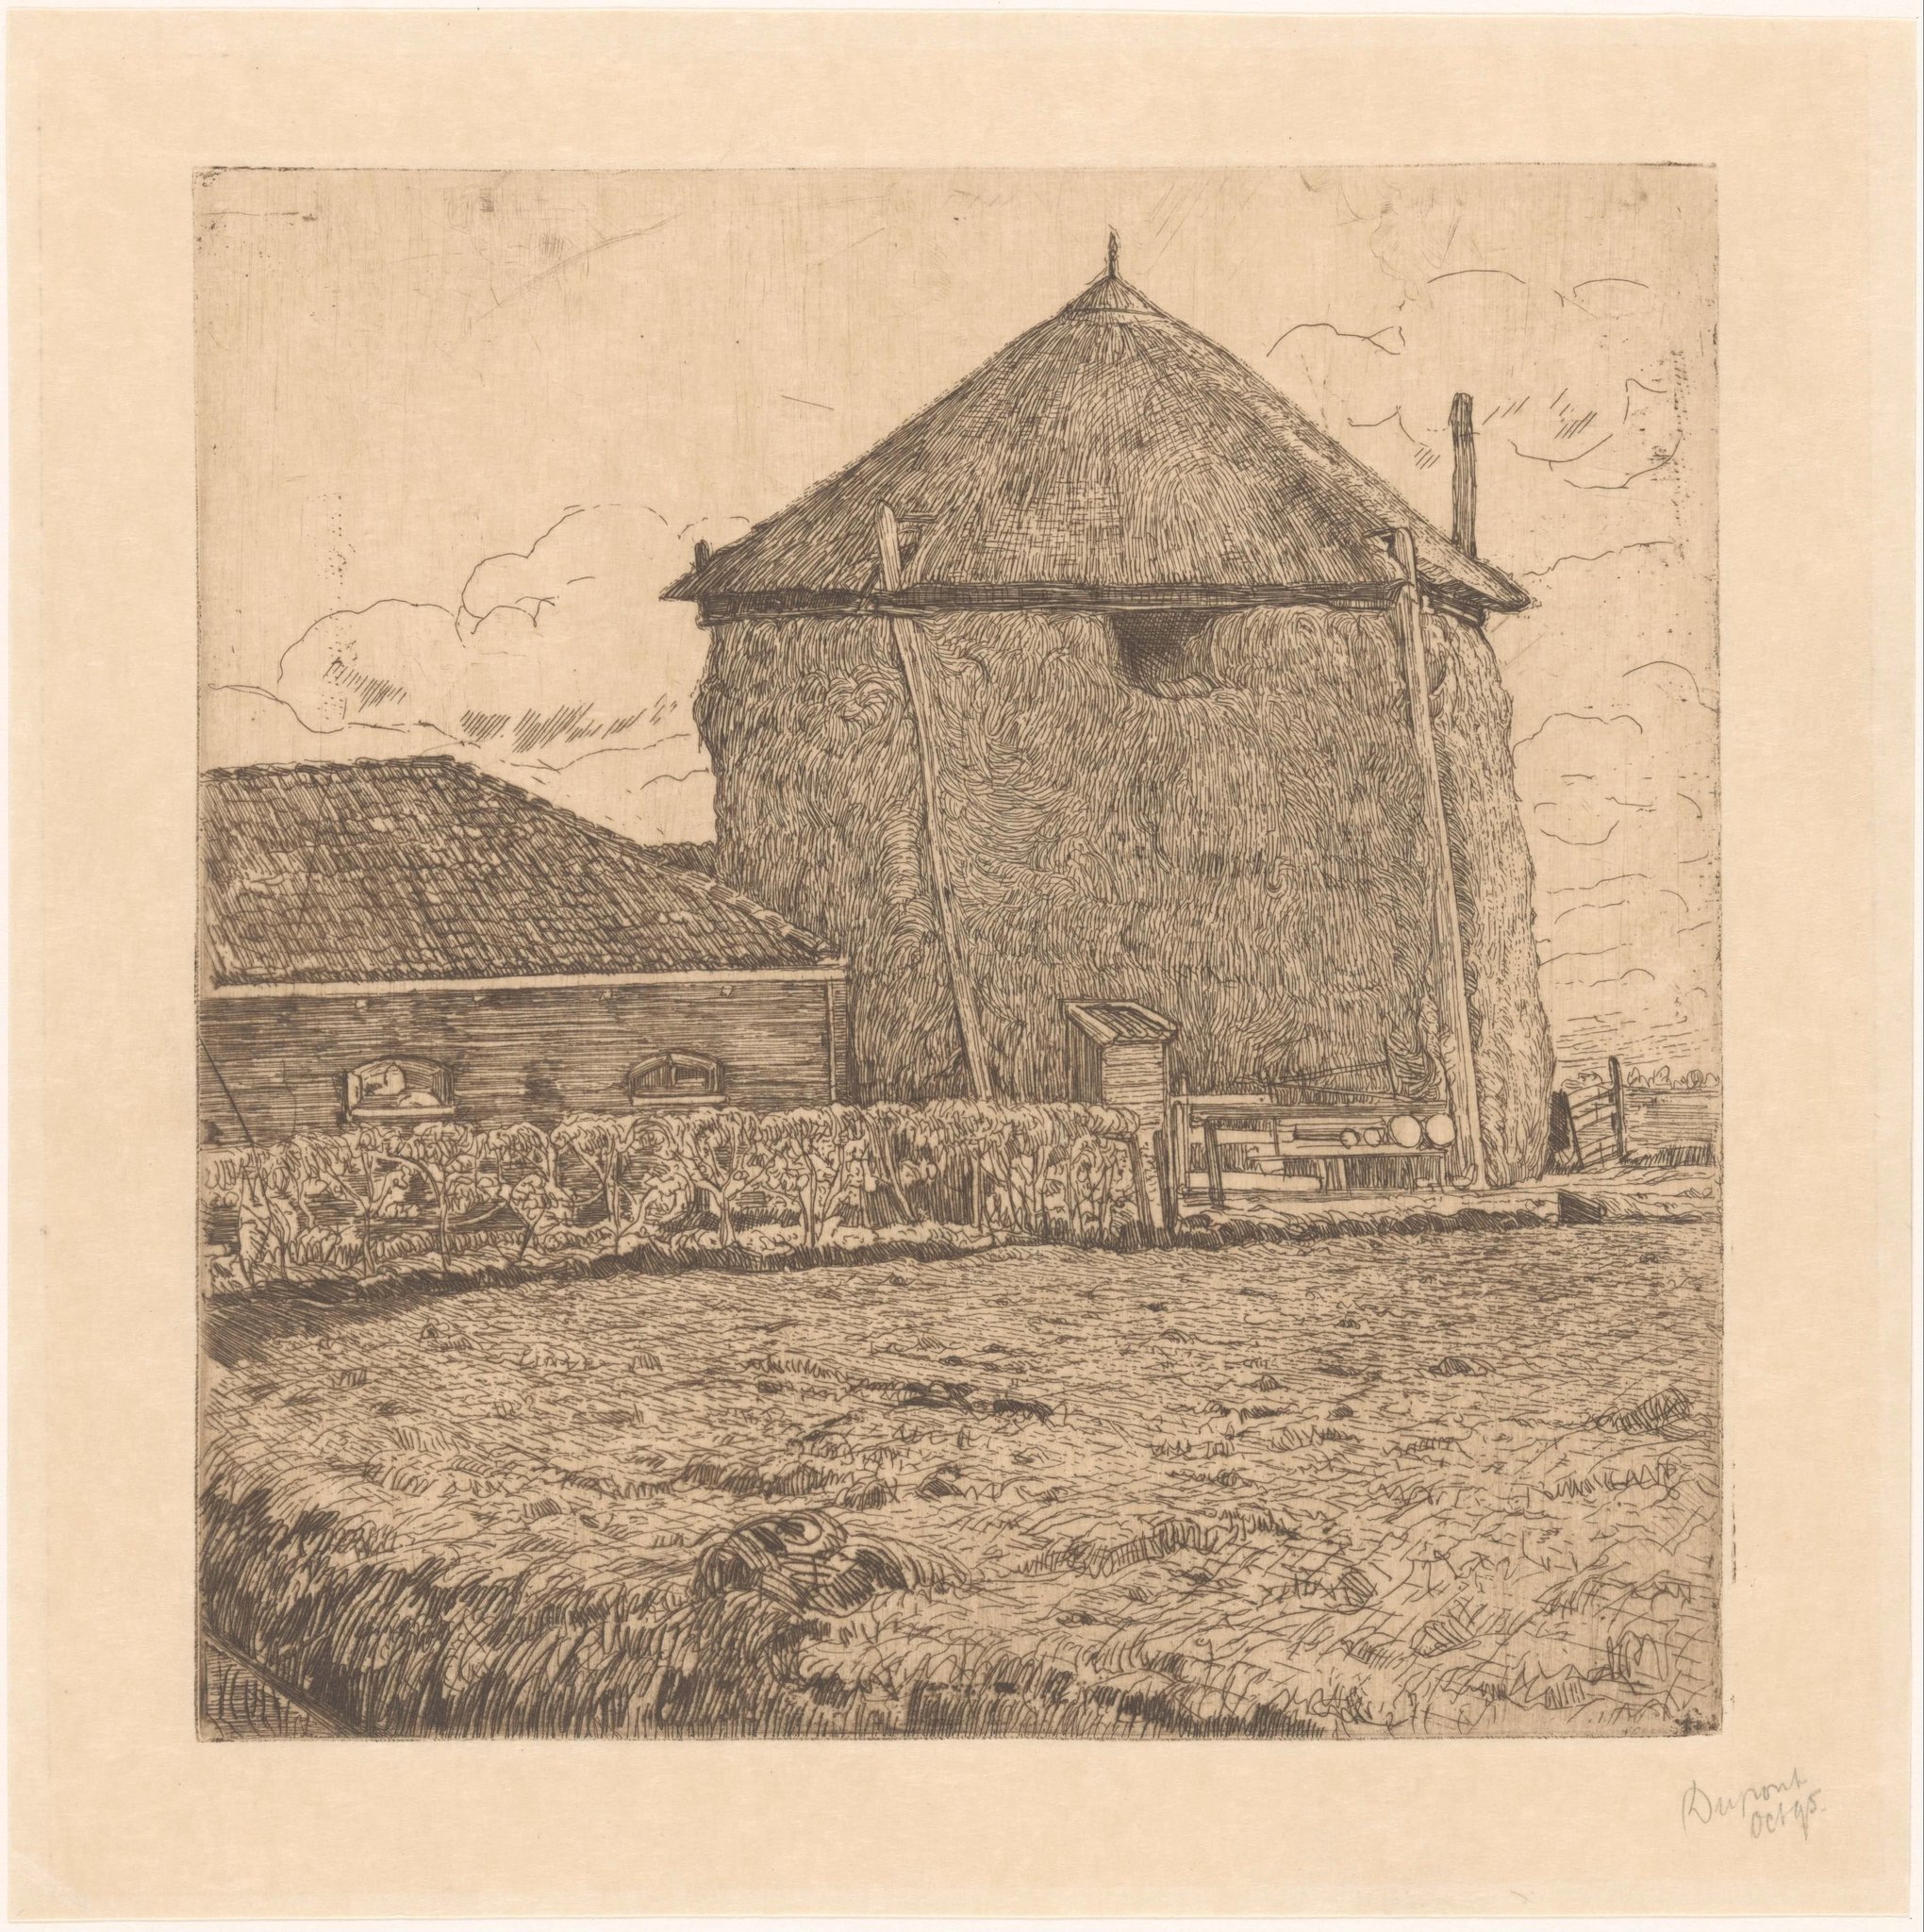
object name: print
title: Boerderij met hooischuur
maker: pieter dupont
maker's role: draughtsman, print maker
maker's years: 1870-1911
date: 1810-1895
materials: paper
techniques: intaglio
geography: sloten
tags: agricultural products and by-products: hay, farm (building)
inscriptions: collector's mark: Lugt 2233